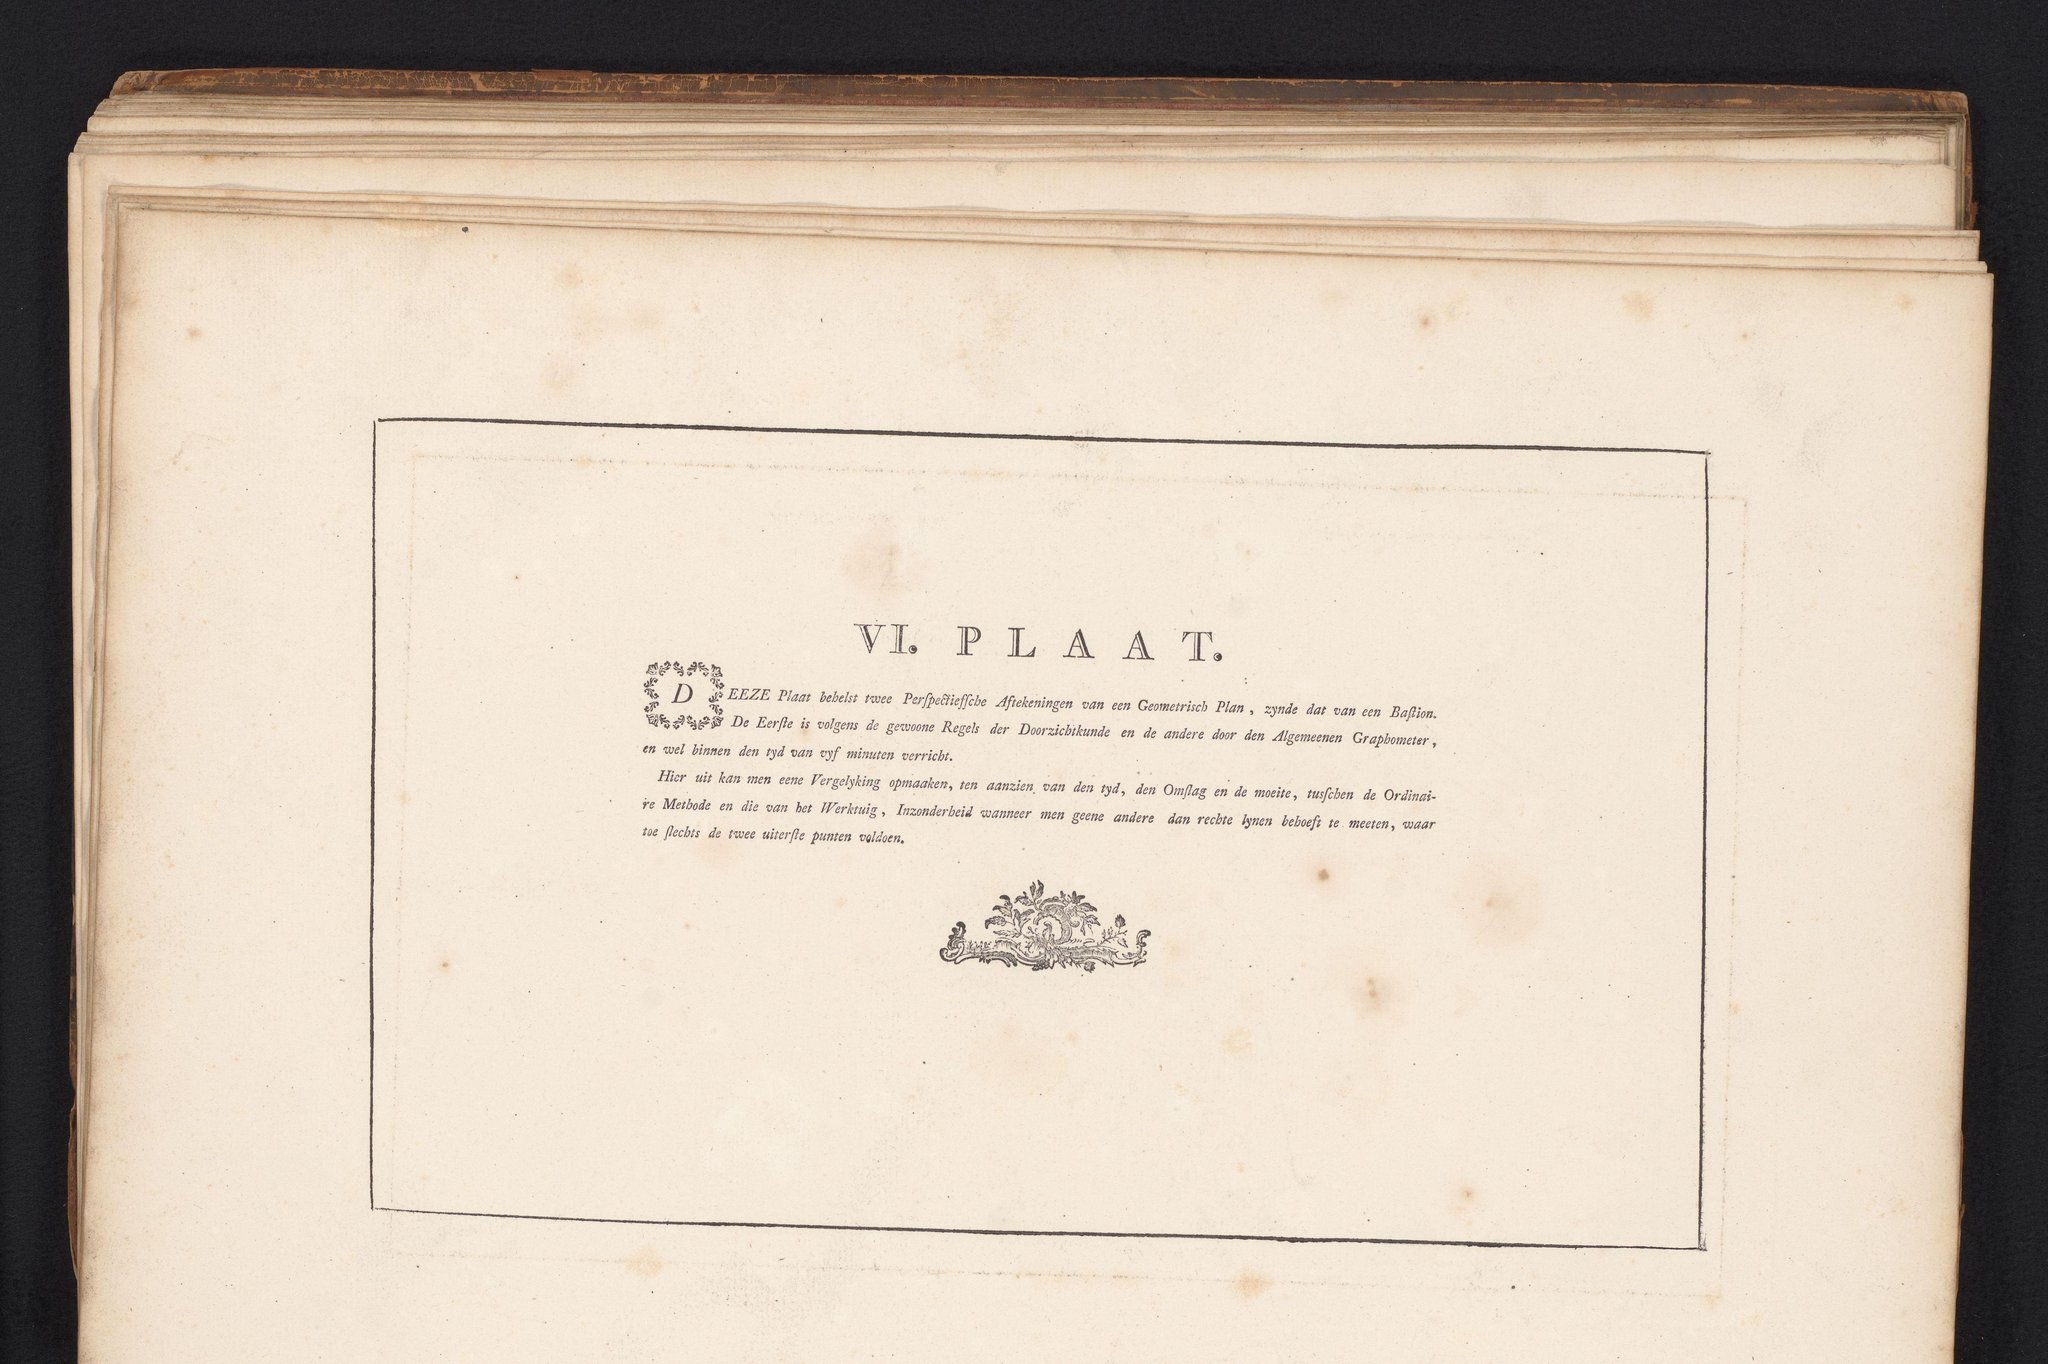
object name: text sheet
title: Toelichting bij een geometrisch plan van een bastion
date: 1777-1778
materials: paper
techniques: letterpress printing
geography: the hague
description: Tekstblad met een Nederlandstalige toelichting op een prent met een voorstelling van een geometrisch plan van een bastion, links getekend volgens de leer van het perspectief (regels der doorzichtkunde) en rechts met behulp van een grafometer. Het tekstblad maakt deel uit van het boek: A.G. Eckhardt, Beschryving van een algemeenen graphometer, 1778.